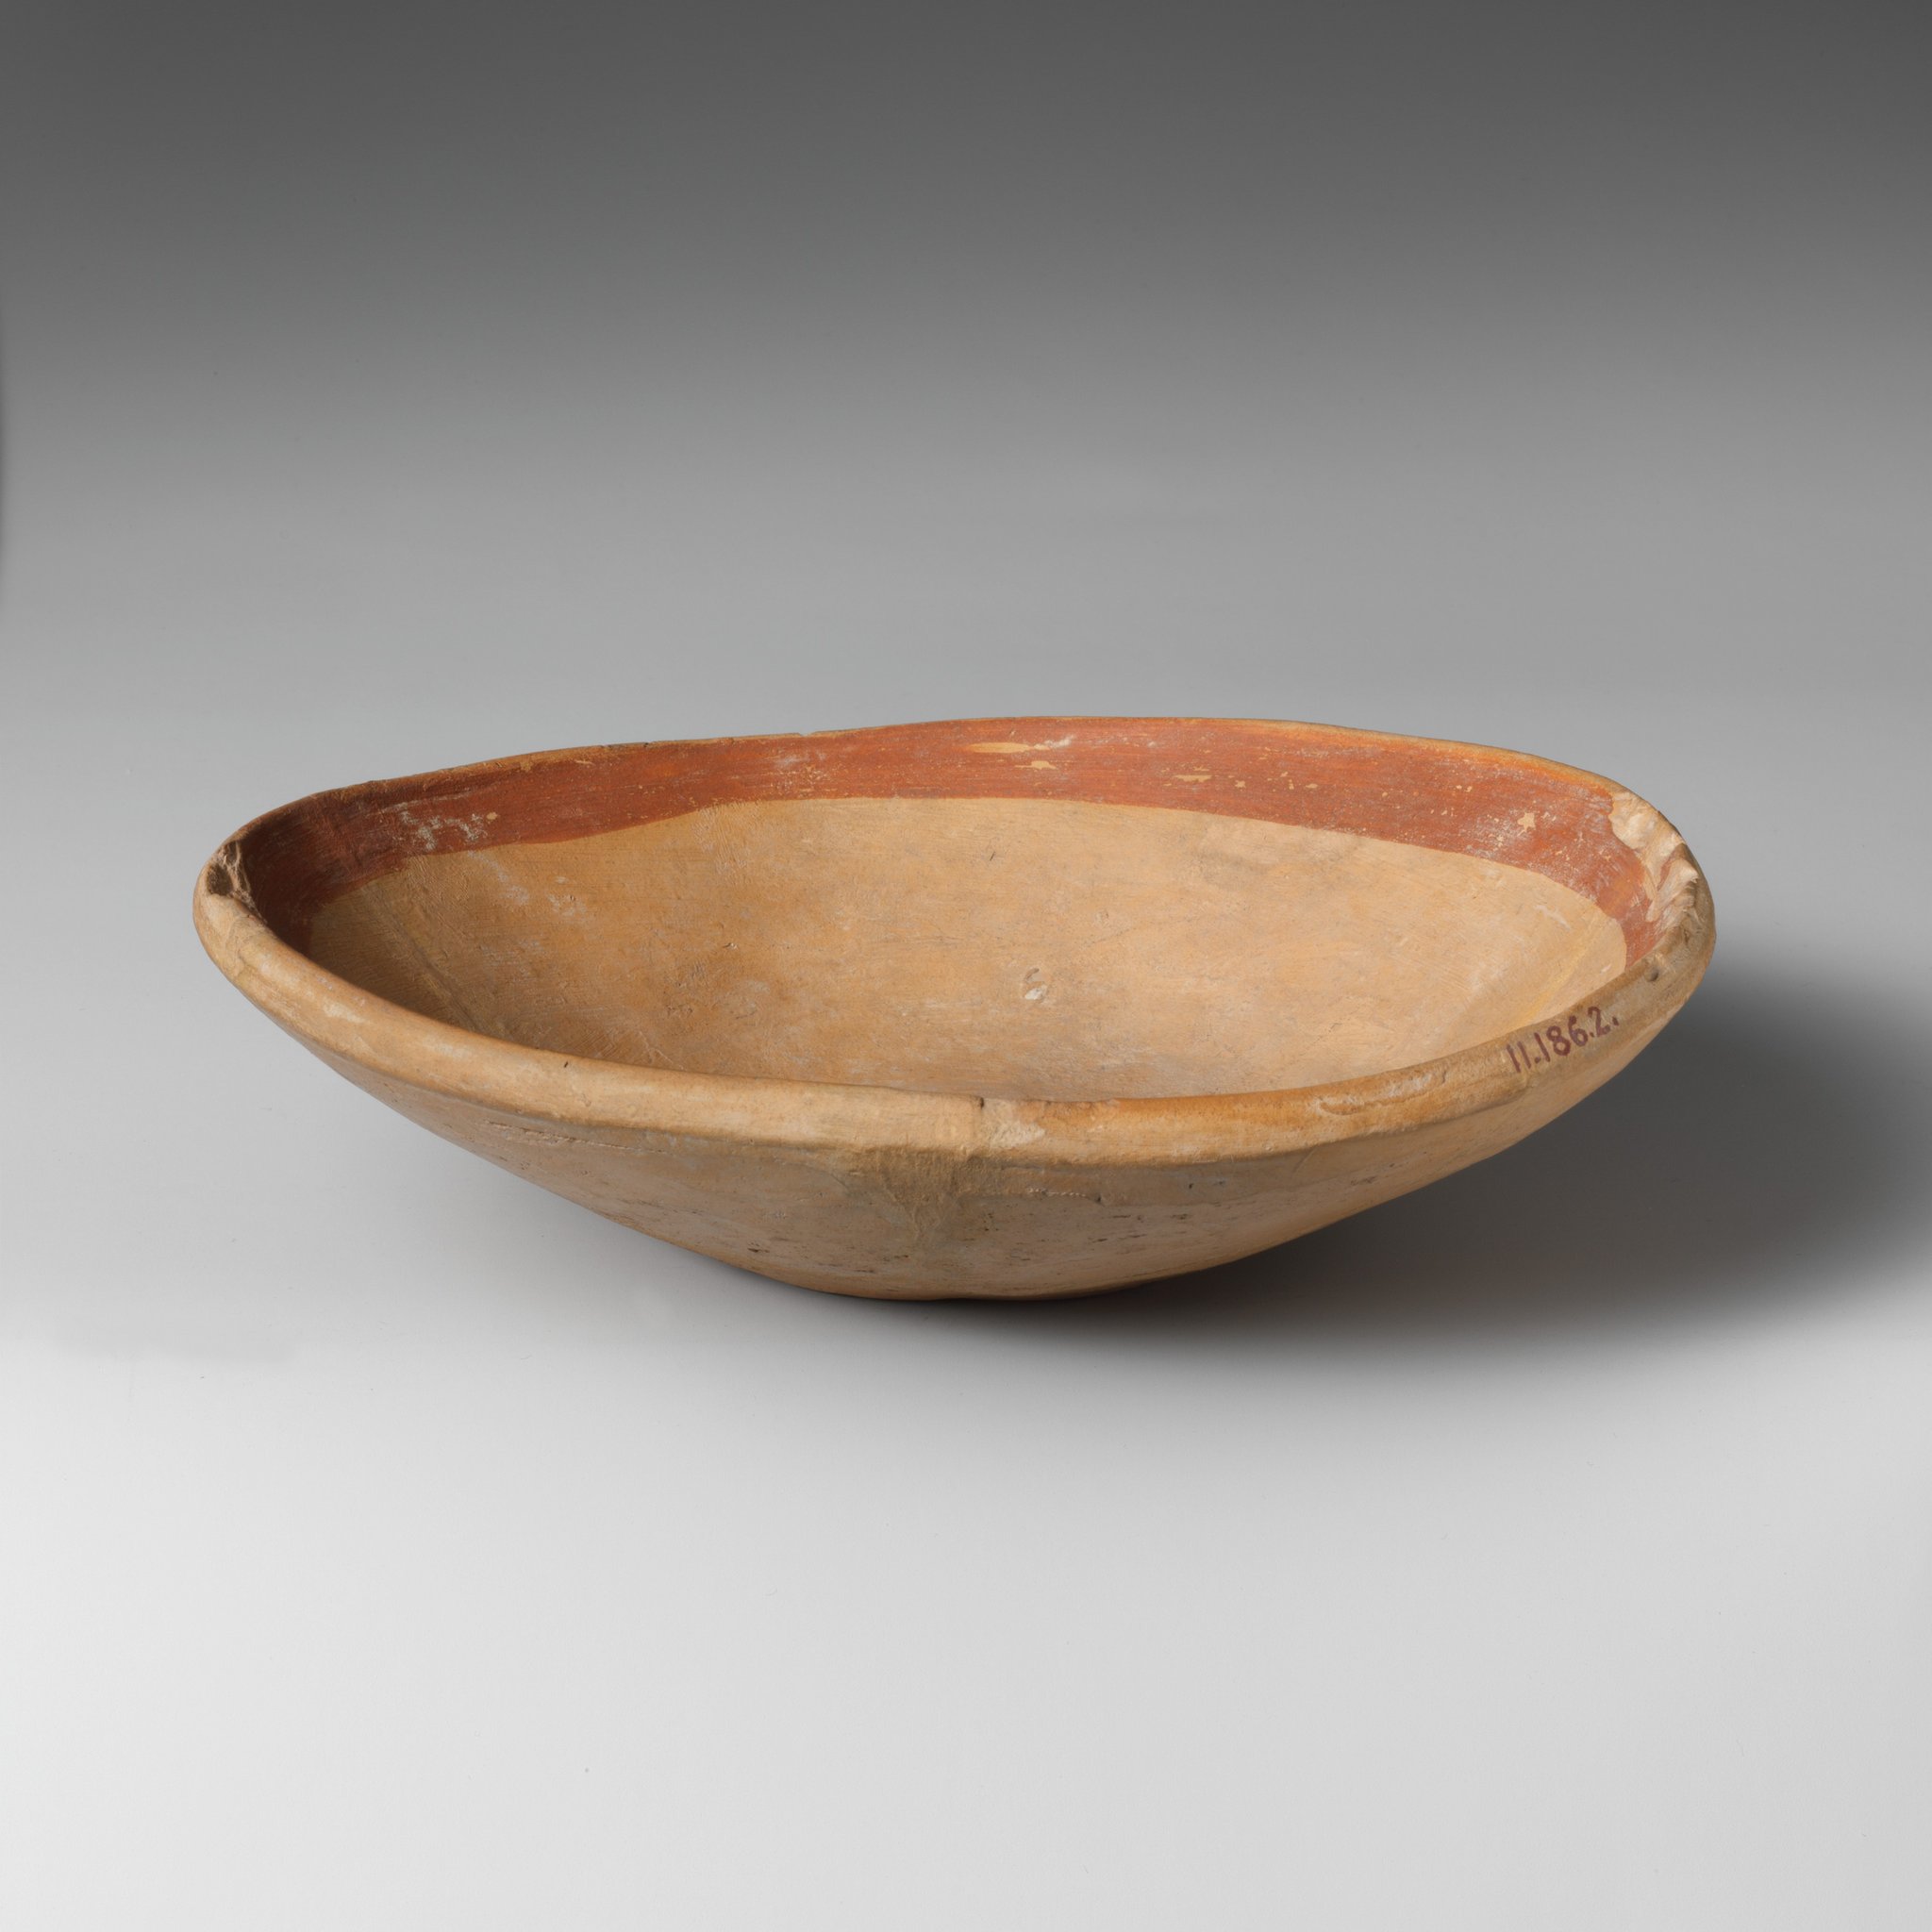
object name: plate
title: Terracotta shallow bowl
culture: minoan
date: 2900-2300 BCE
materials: terracotta